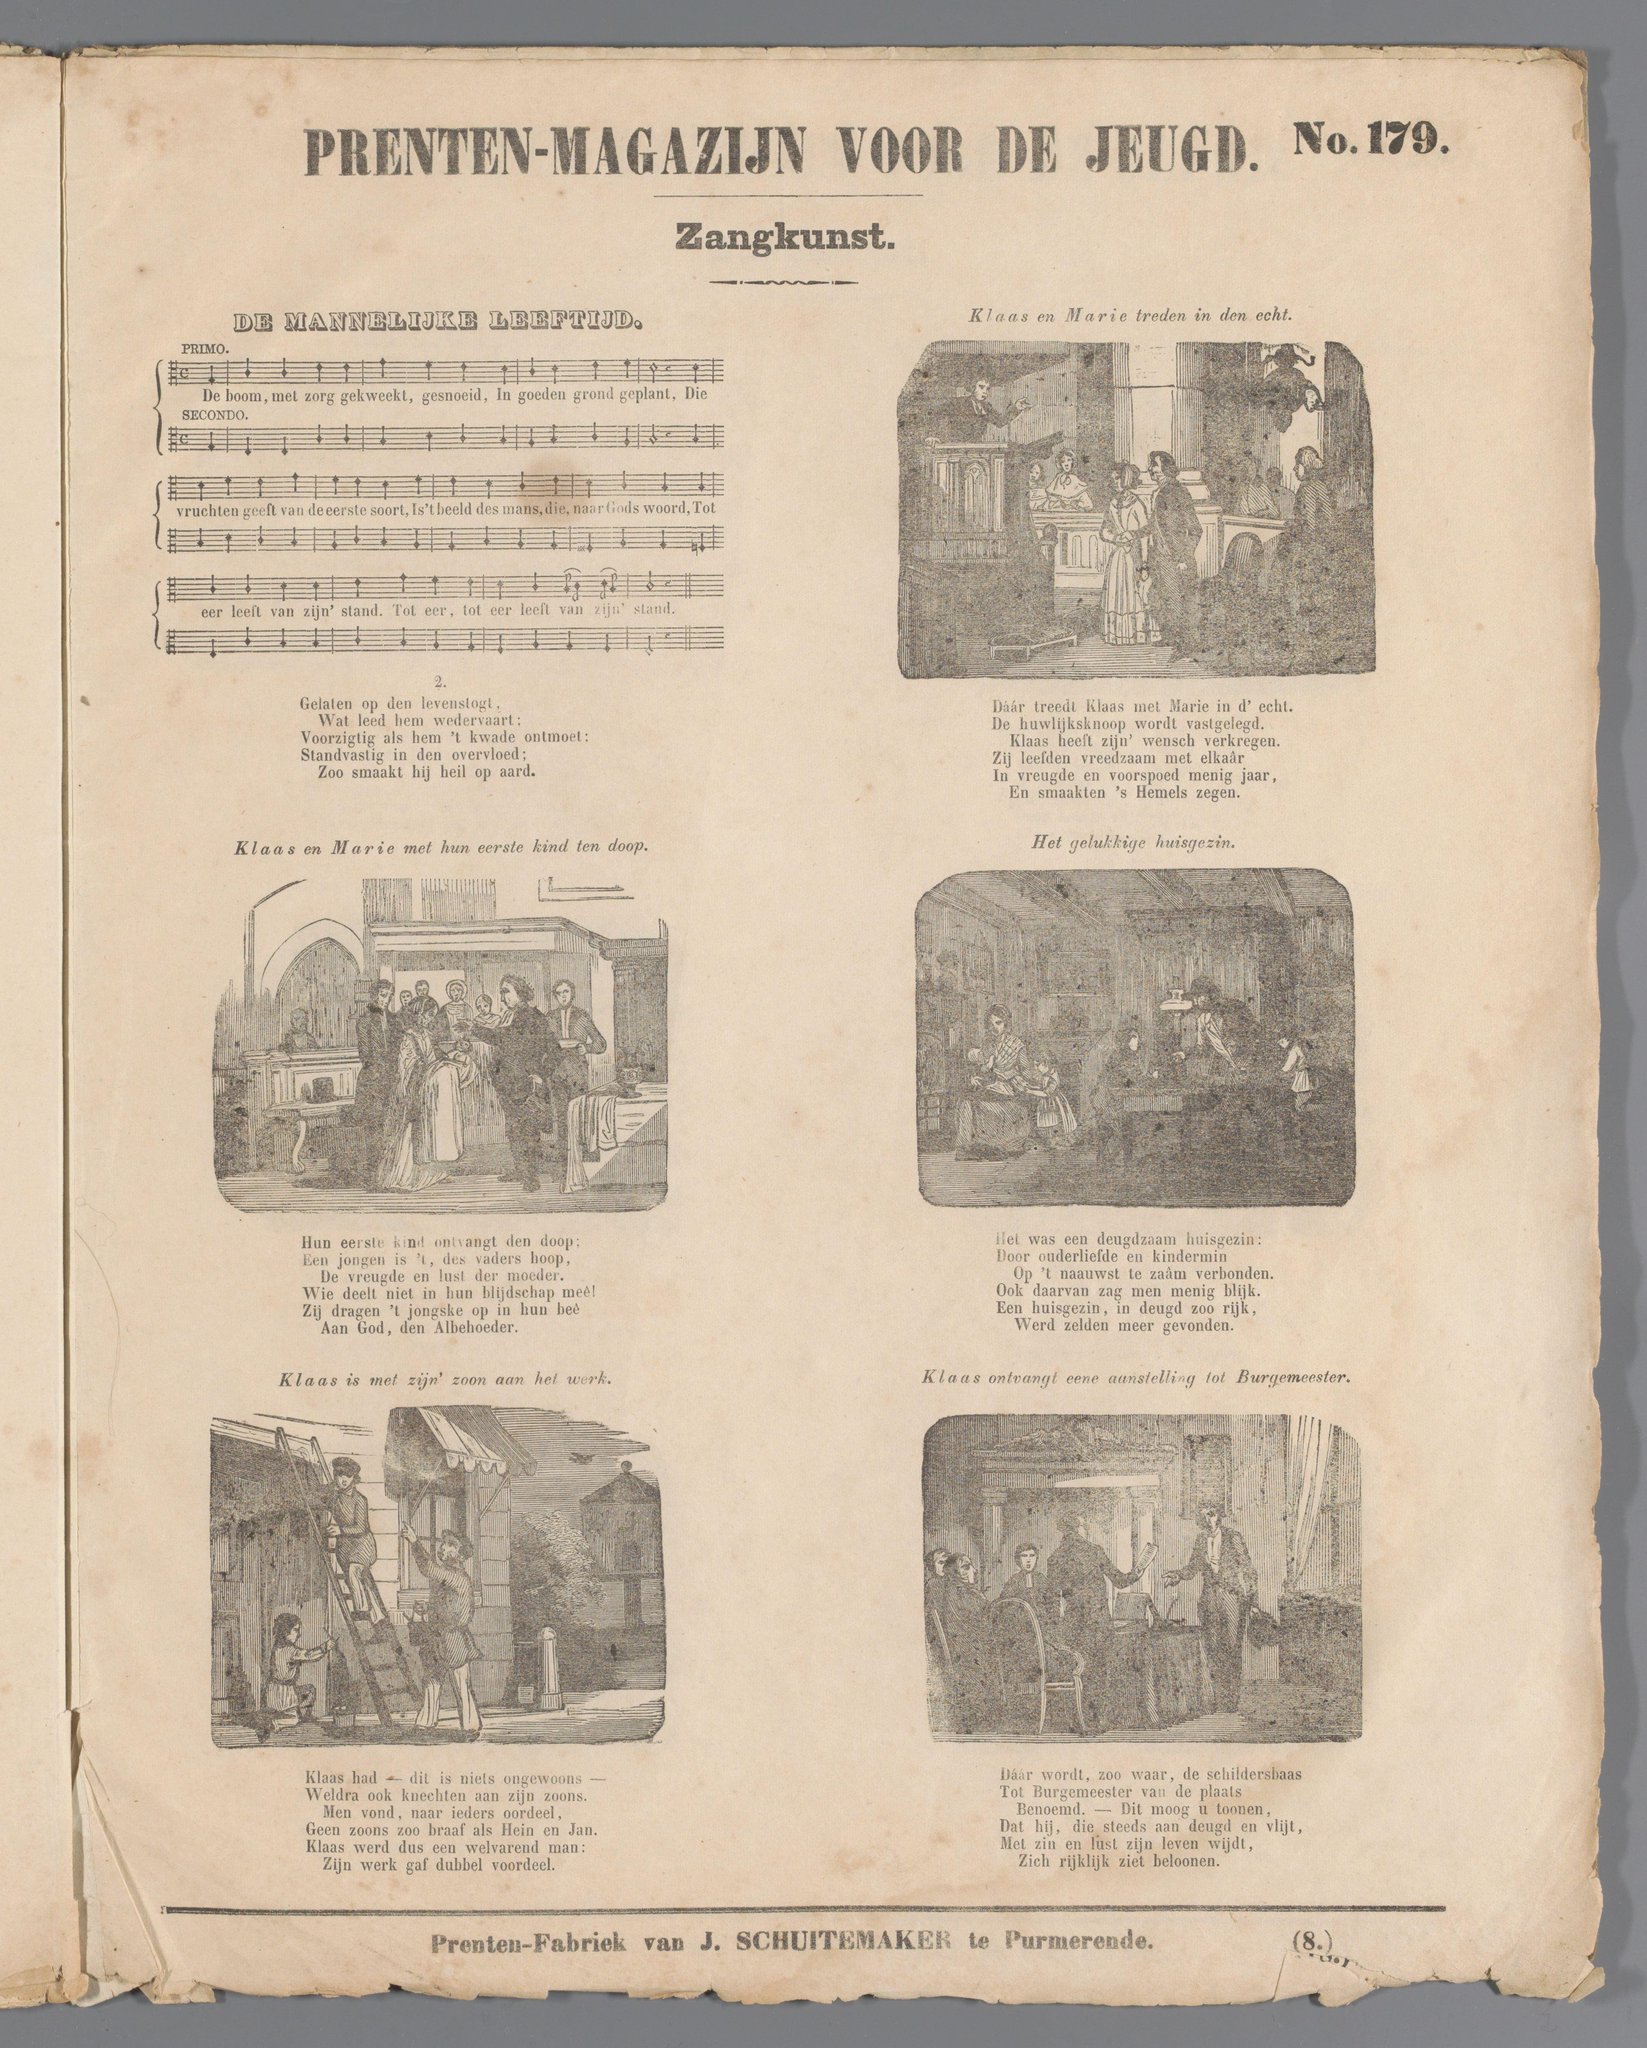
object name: print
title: Groot en goed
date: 1853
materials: paper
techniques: letterpress printing, engraving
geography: purmerend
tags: baptism, christening ceremony ~ the first of the seven sacraments, family life at home, printed edition of musical score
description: Blad met muziekstuk 'De mannelijke leeftijd' en 5 voorstellingen: Klaas en Marie treden in den echt, Klaas en Marie met hun eerste kind ten doop, het gelukkige huisgezin, Klaas met zijn zoon aan het werk en Klaas ontvangt een aanstelling tot burgemeester. Onder de voorstellingen diverse coupletten van het muziekstuk. Genummerd rechtsboven: No. 179, linksonder: (8.).